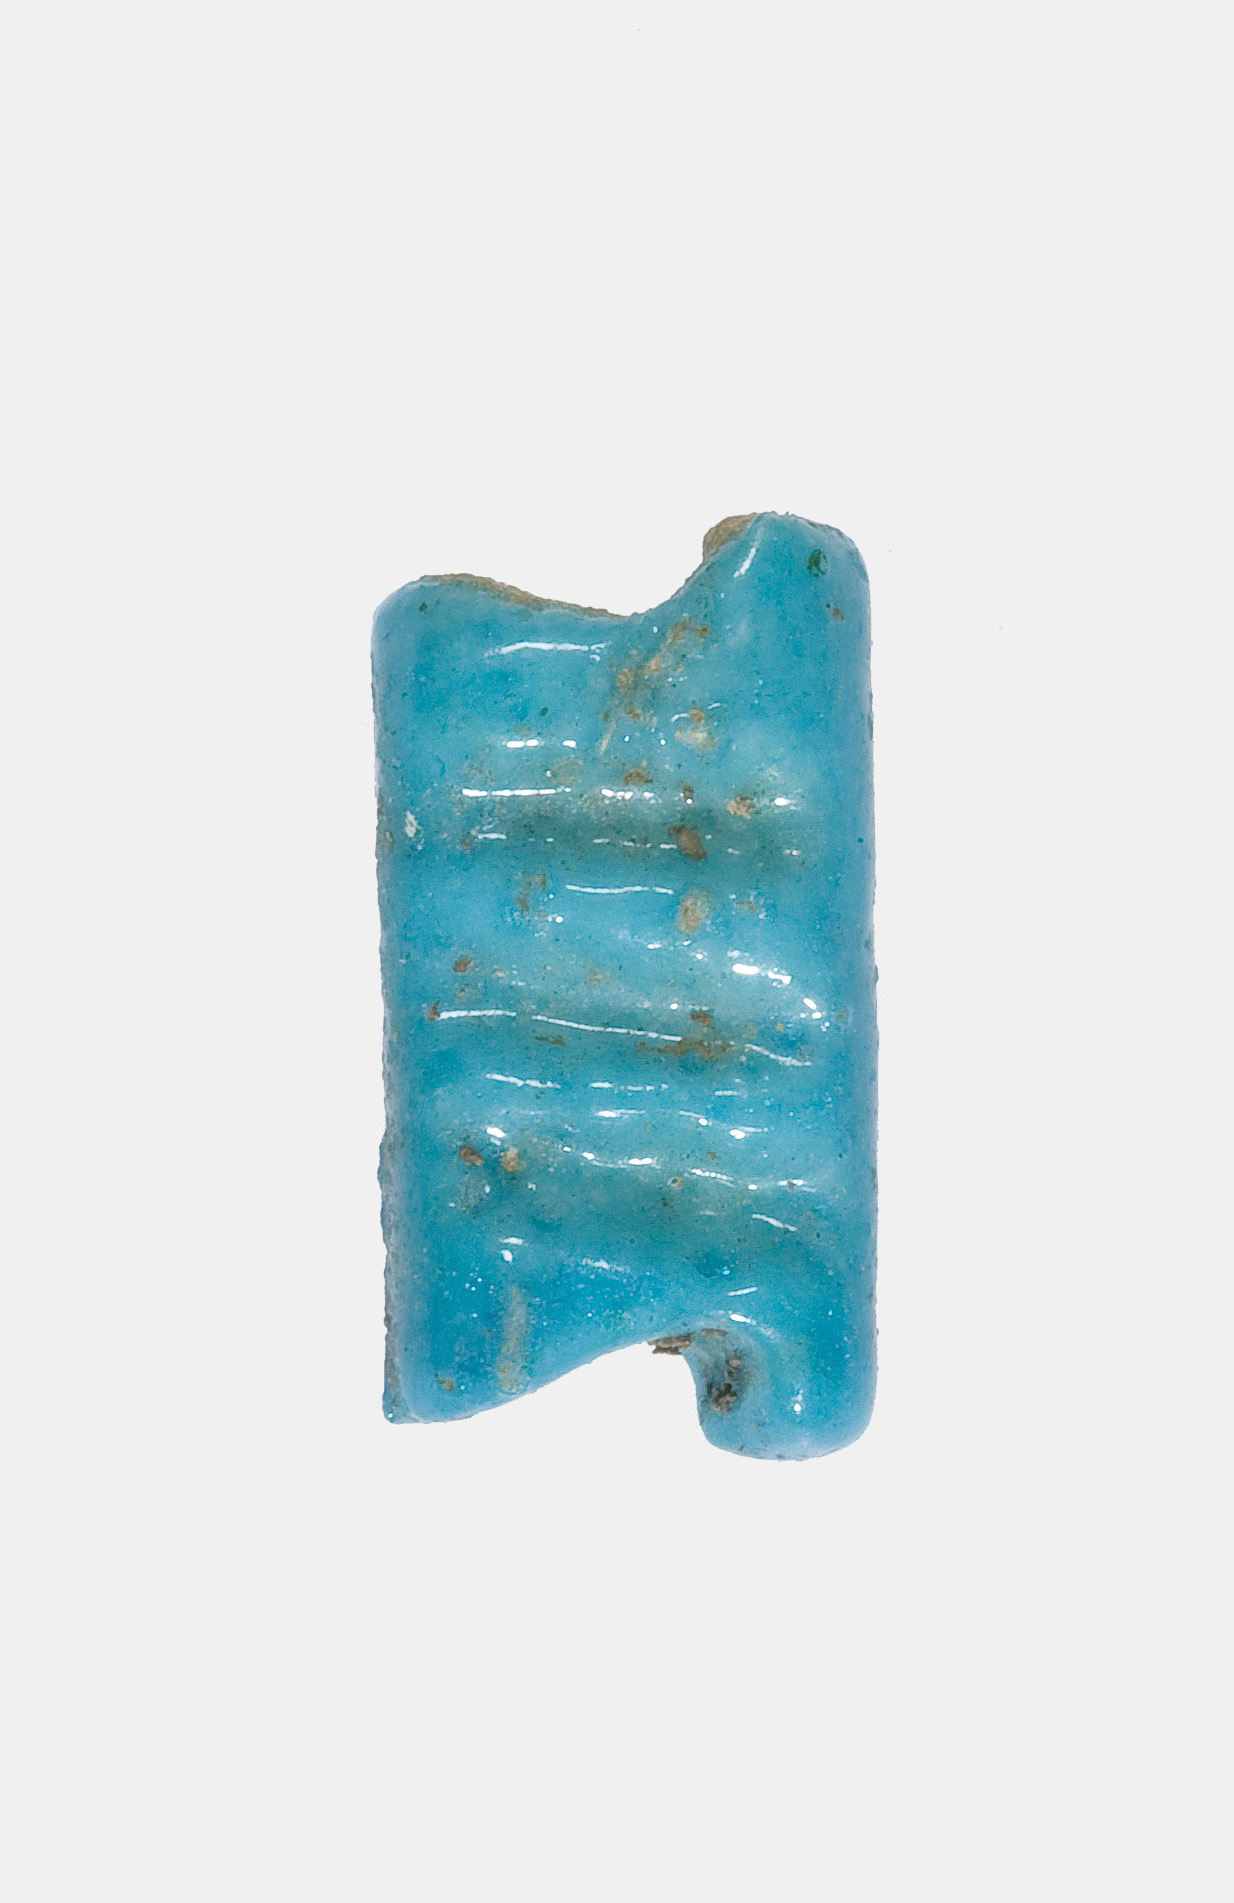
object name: necklace, bead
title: Amulet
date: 1802-1450 BCE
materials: faience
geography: egypt